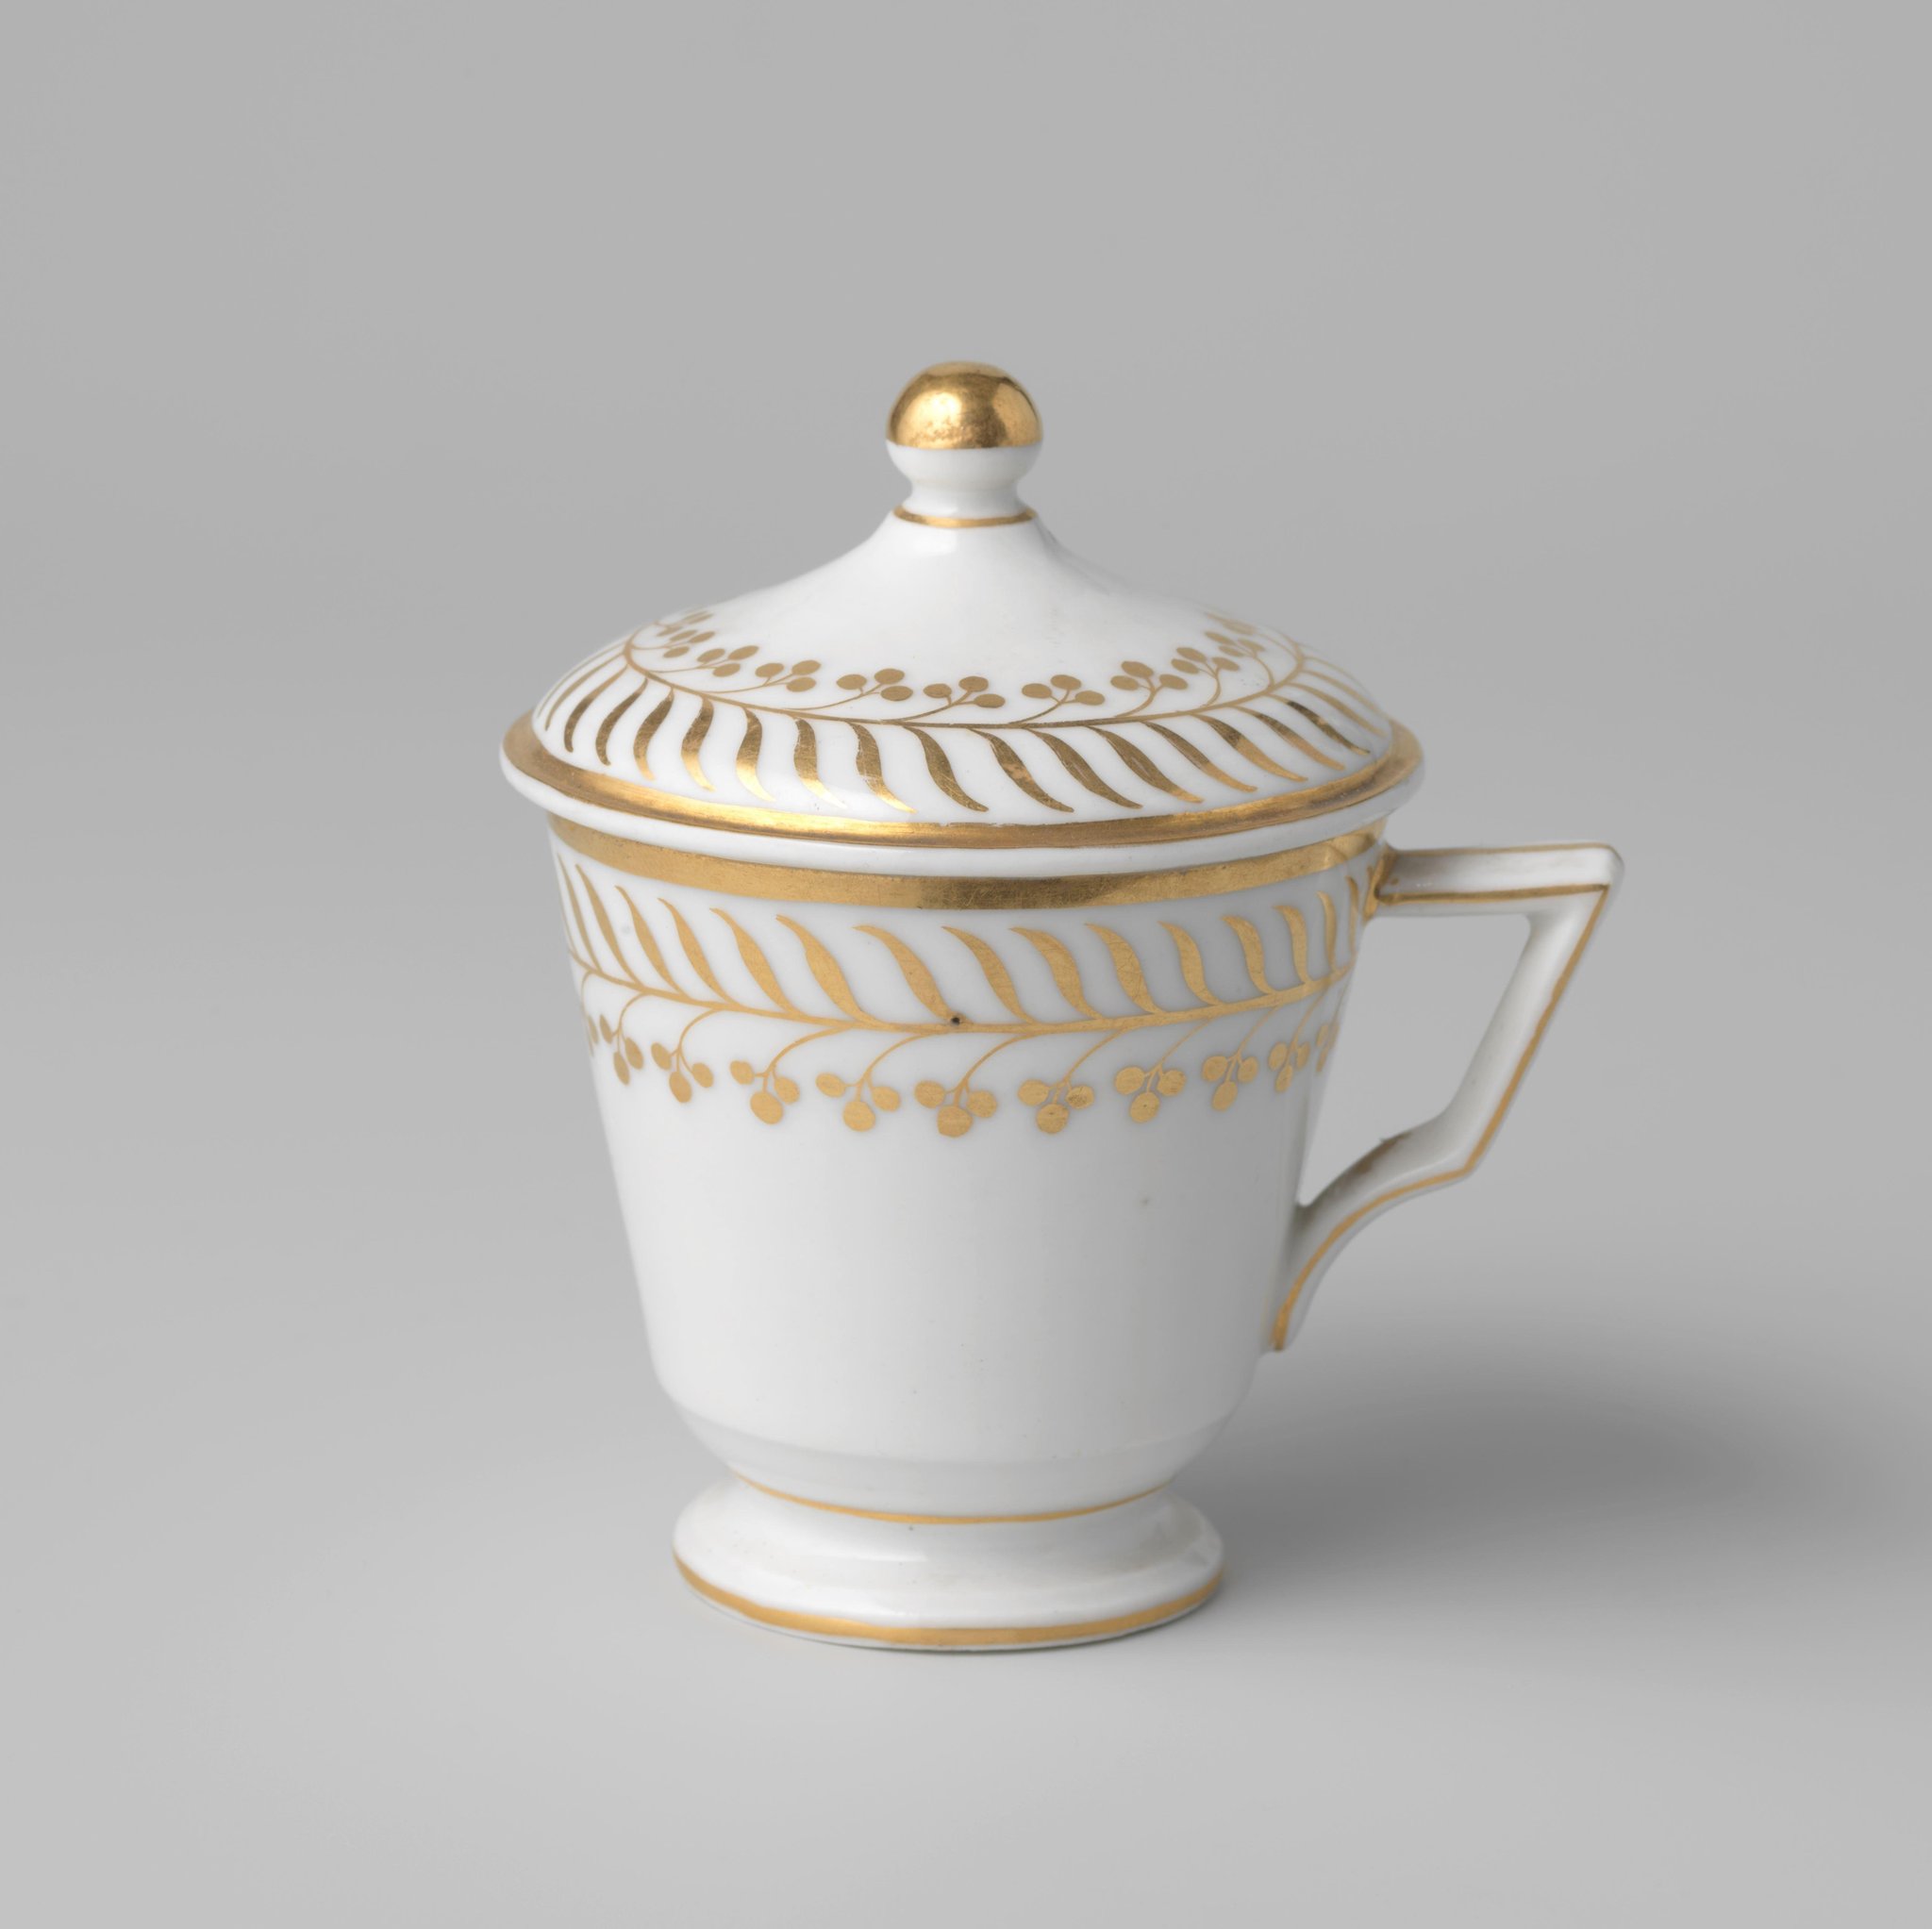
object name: crèmepot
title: Cover of a cup (pot de crème) with stylized floral scrolls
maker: Anonymous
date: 1800-1810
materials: glaze, gold, paint, porcelain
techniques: firing, forming, gilding, vitrification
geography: france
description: Deksel van porselein waarop een vergulde knop. Versierd met gouden biezen en langs de randen beschilderd met een doorlopende tak met aan de ene zijde bladeren, aan de andere zijde steeds een tak met drie vruchten.